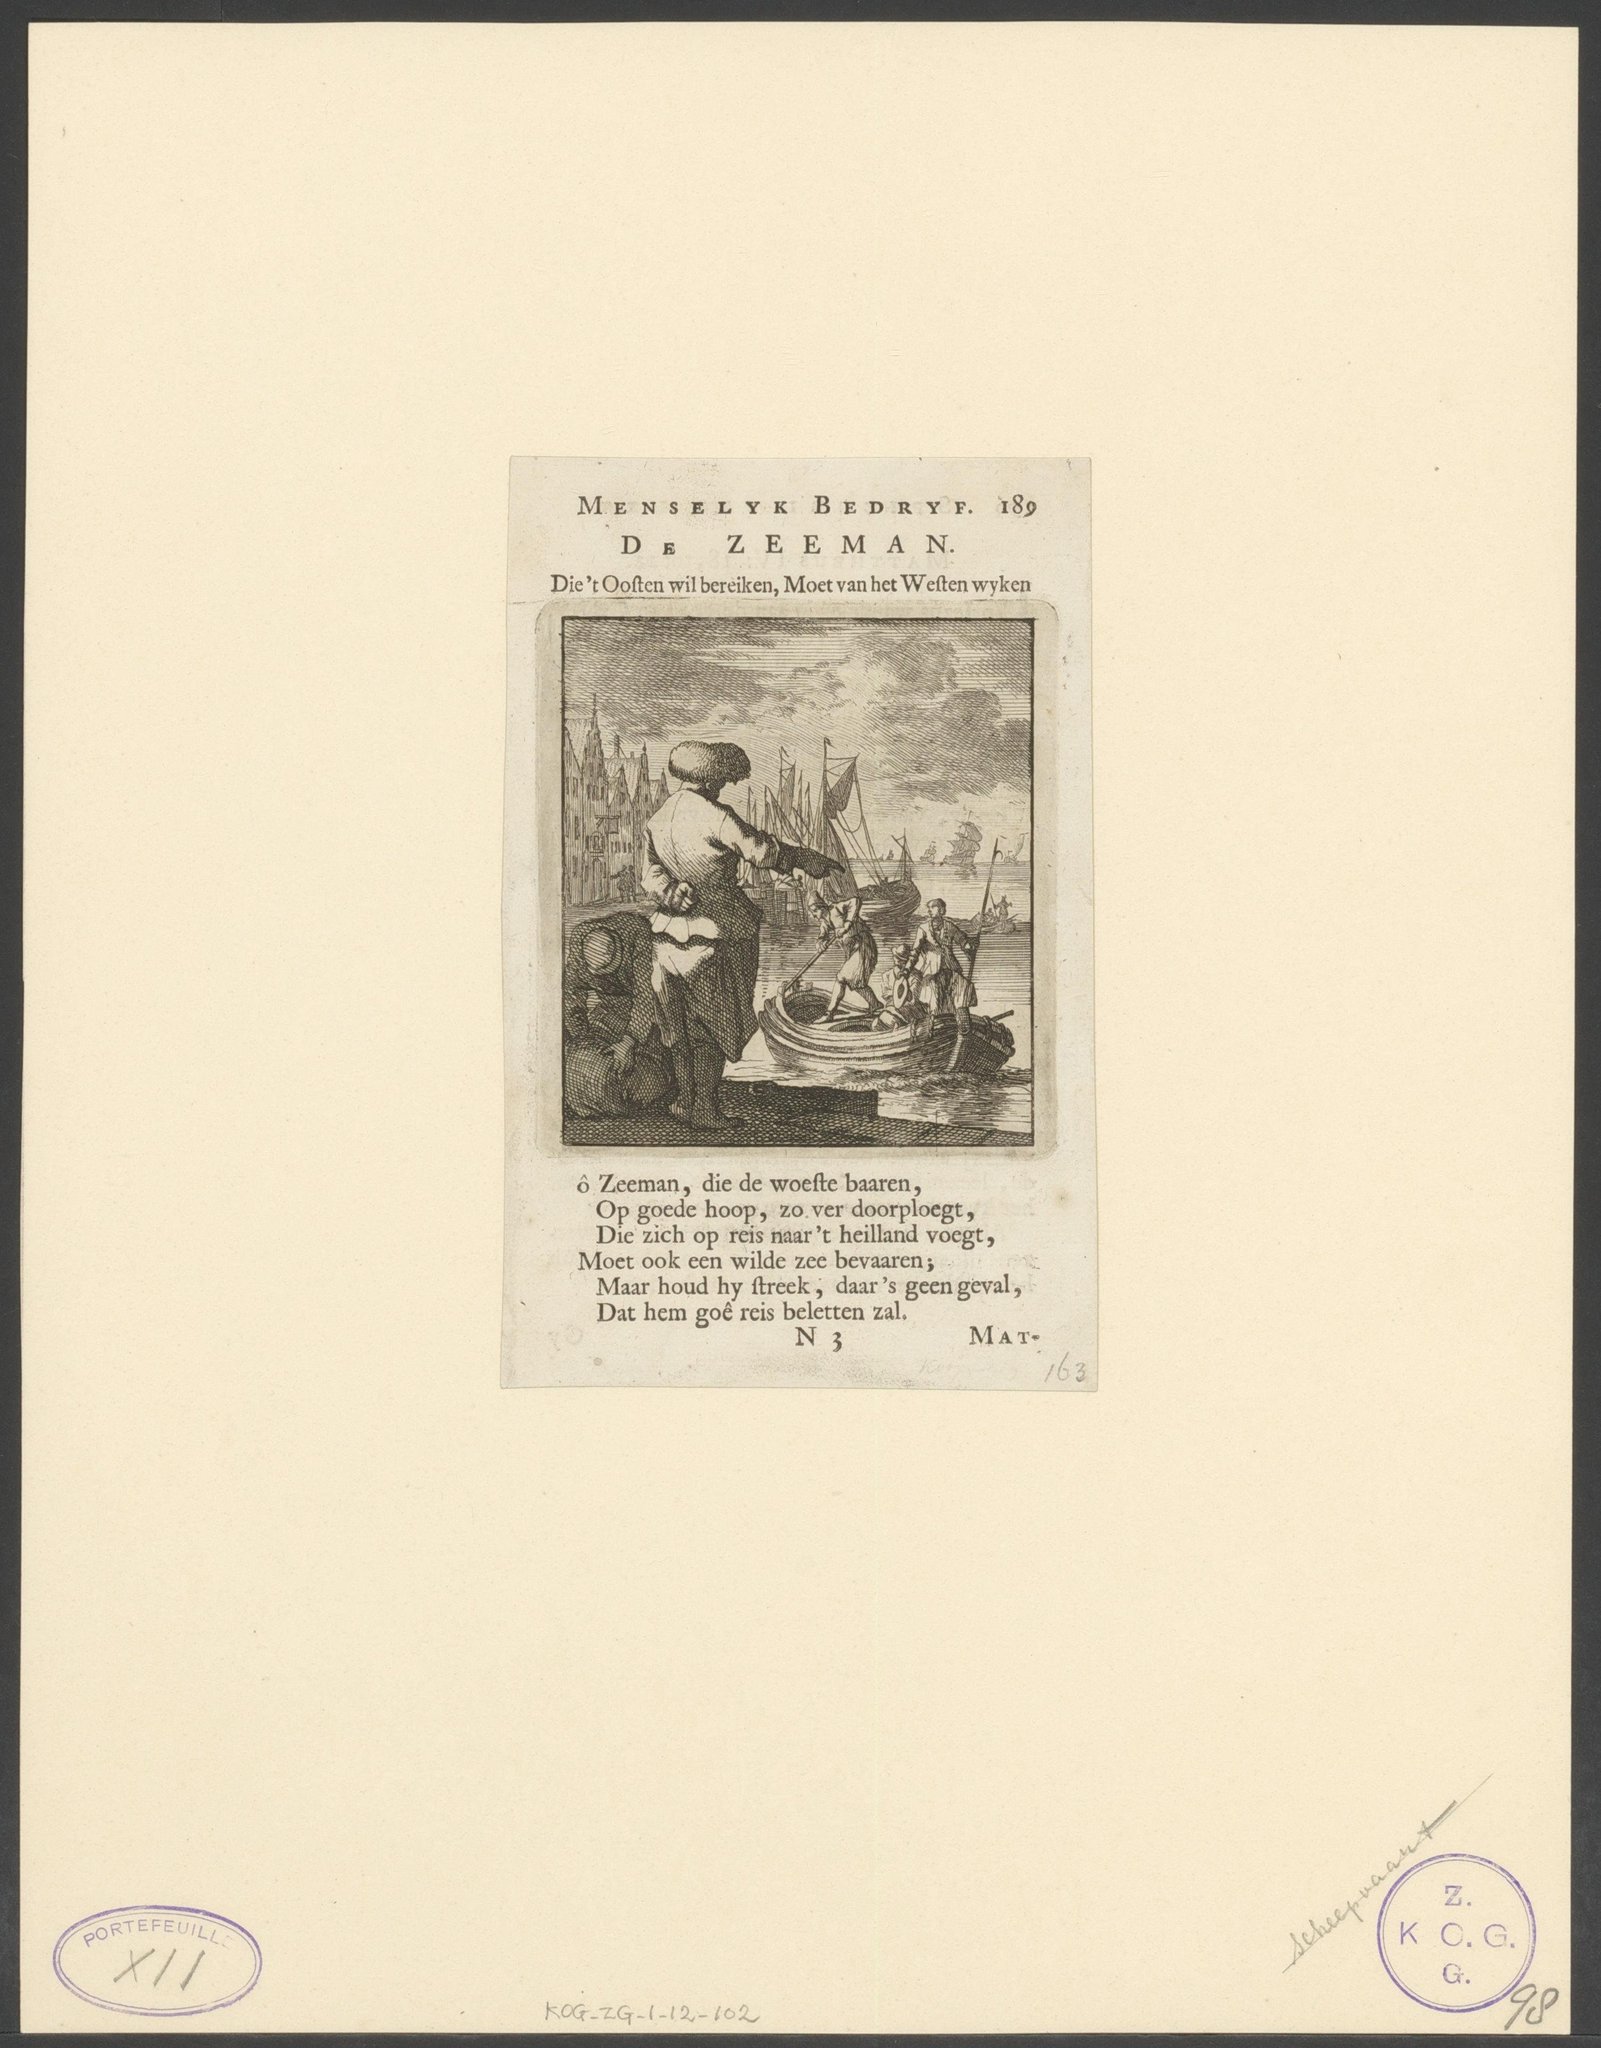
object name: print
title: De zeeman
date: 1718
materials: paper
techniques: etching, letterpress printing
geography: amsterdam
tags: seaman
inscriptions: stamp, collector's mark: Lugt 1641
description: Prent voor het eerst verschenen in de 100-delige serie beroepsprenten van Jan en Caspar Luyken, getiteld: Het menselyk bedryf. S.l.s.n., 1694 (eerste druk). Huidige staat uit: Luyken, Jan en Caspar. Spiegel van het menselyk bedryf (...). Amsterdam: Cornelis van der Sys, 1718, 189.